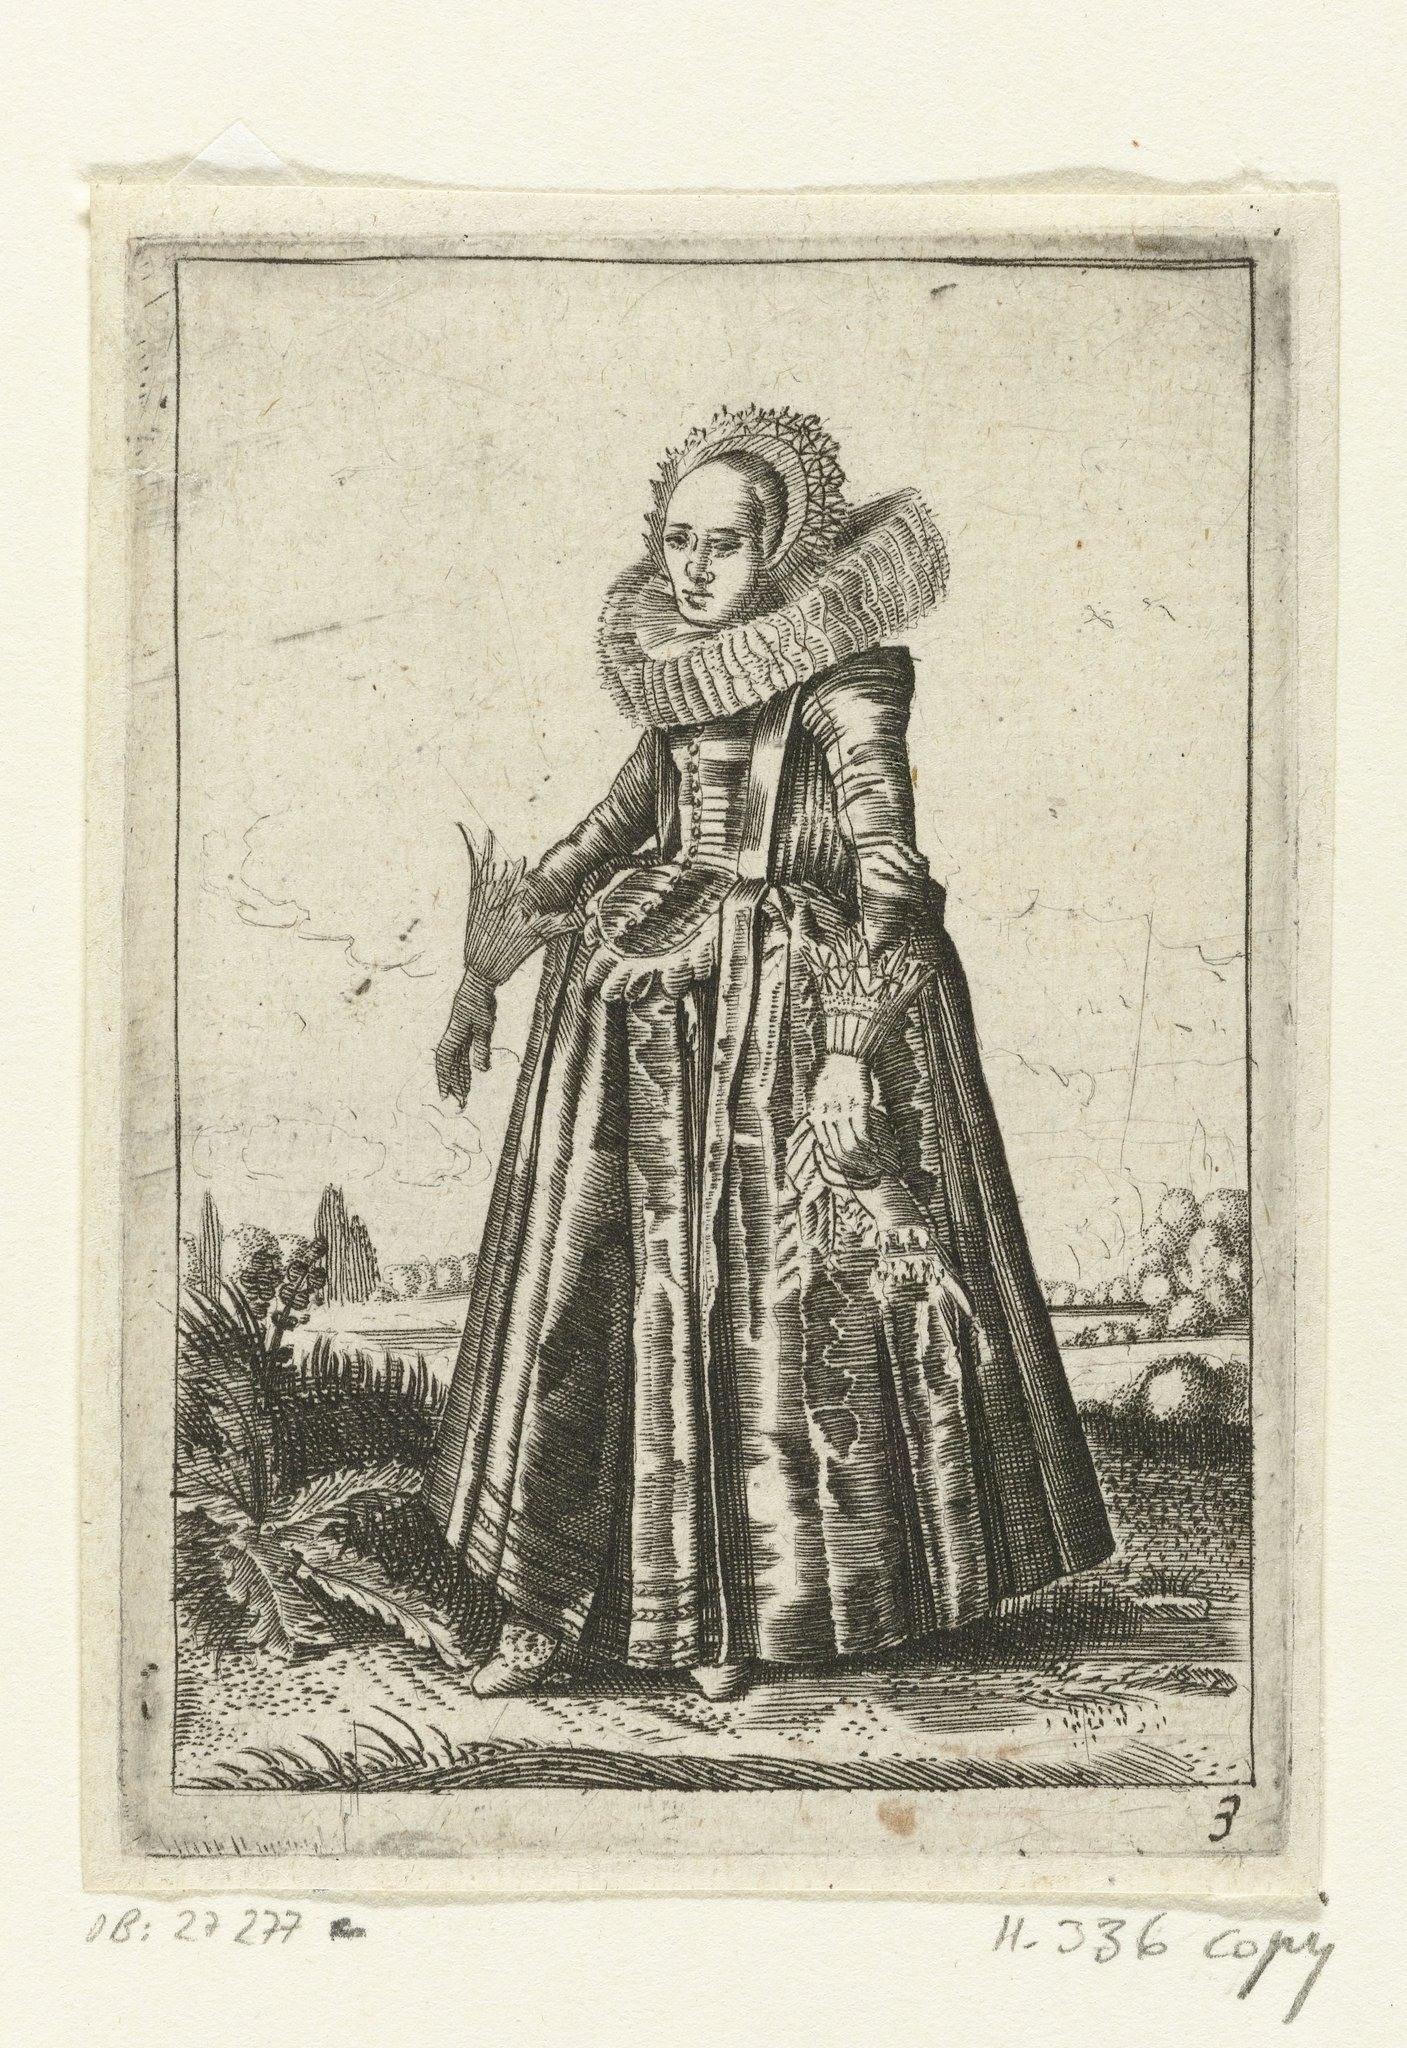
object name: costume print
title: Klederdracht van Nederlandse edelvrouwen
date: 1619-1652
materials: paper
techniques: engraving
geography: amsterdam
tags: clothes, costume (+ women's clothes), handkerchief, europeans (with name)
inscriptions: collector's mark: Lugt 240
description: Dame, gekleed volgens de mode van ca. 1620, staand in landschap, van voren gezien, iets naar rechts gekeerd. Ze draagt een vliegerkostuum, waarvan het lijfje een brede lage afronding heeft, en een geplooide rok (over een heupwrong). De nauwe mouwen zijn afgezet met grote trechtervormige kanten manchetten. Om haar hals een brede molensteen kraag, afgezet met kant. Op haar hoofd een boogjesmuts of diadeemmuts. In haar rechterhand houdt ze een zakdoek vast.